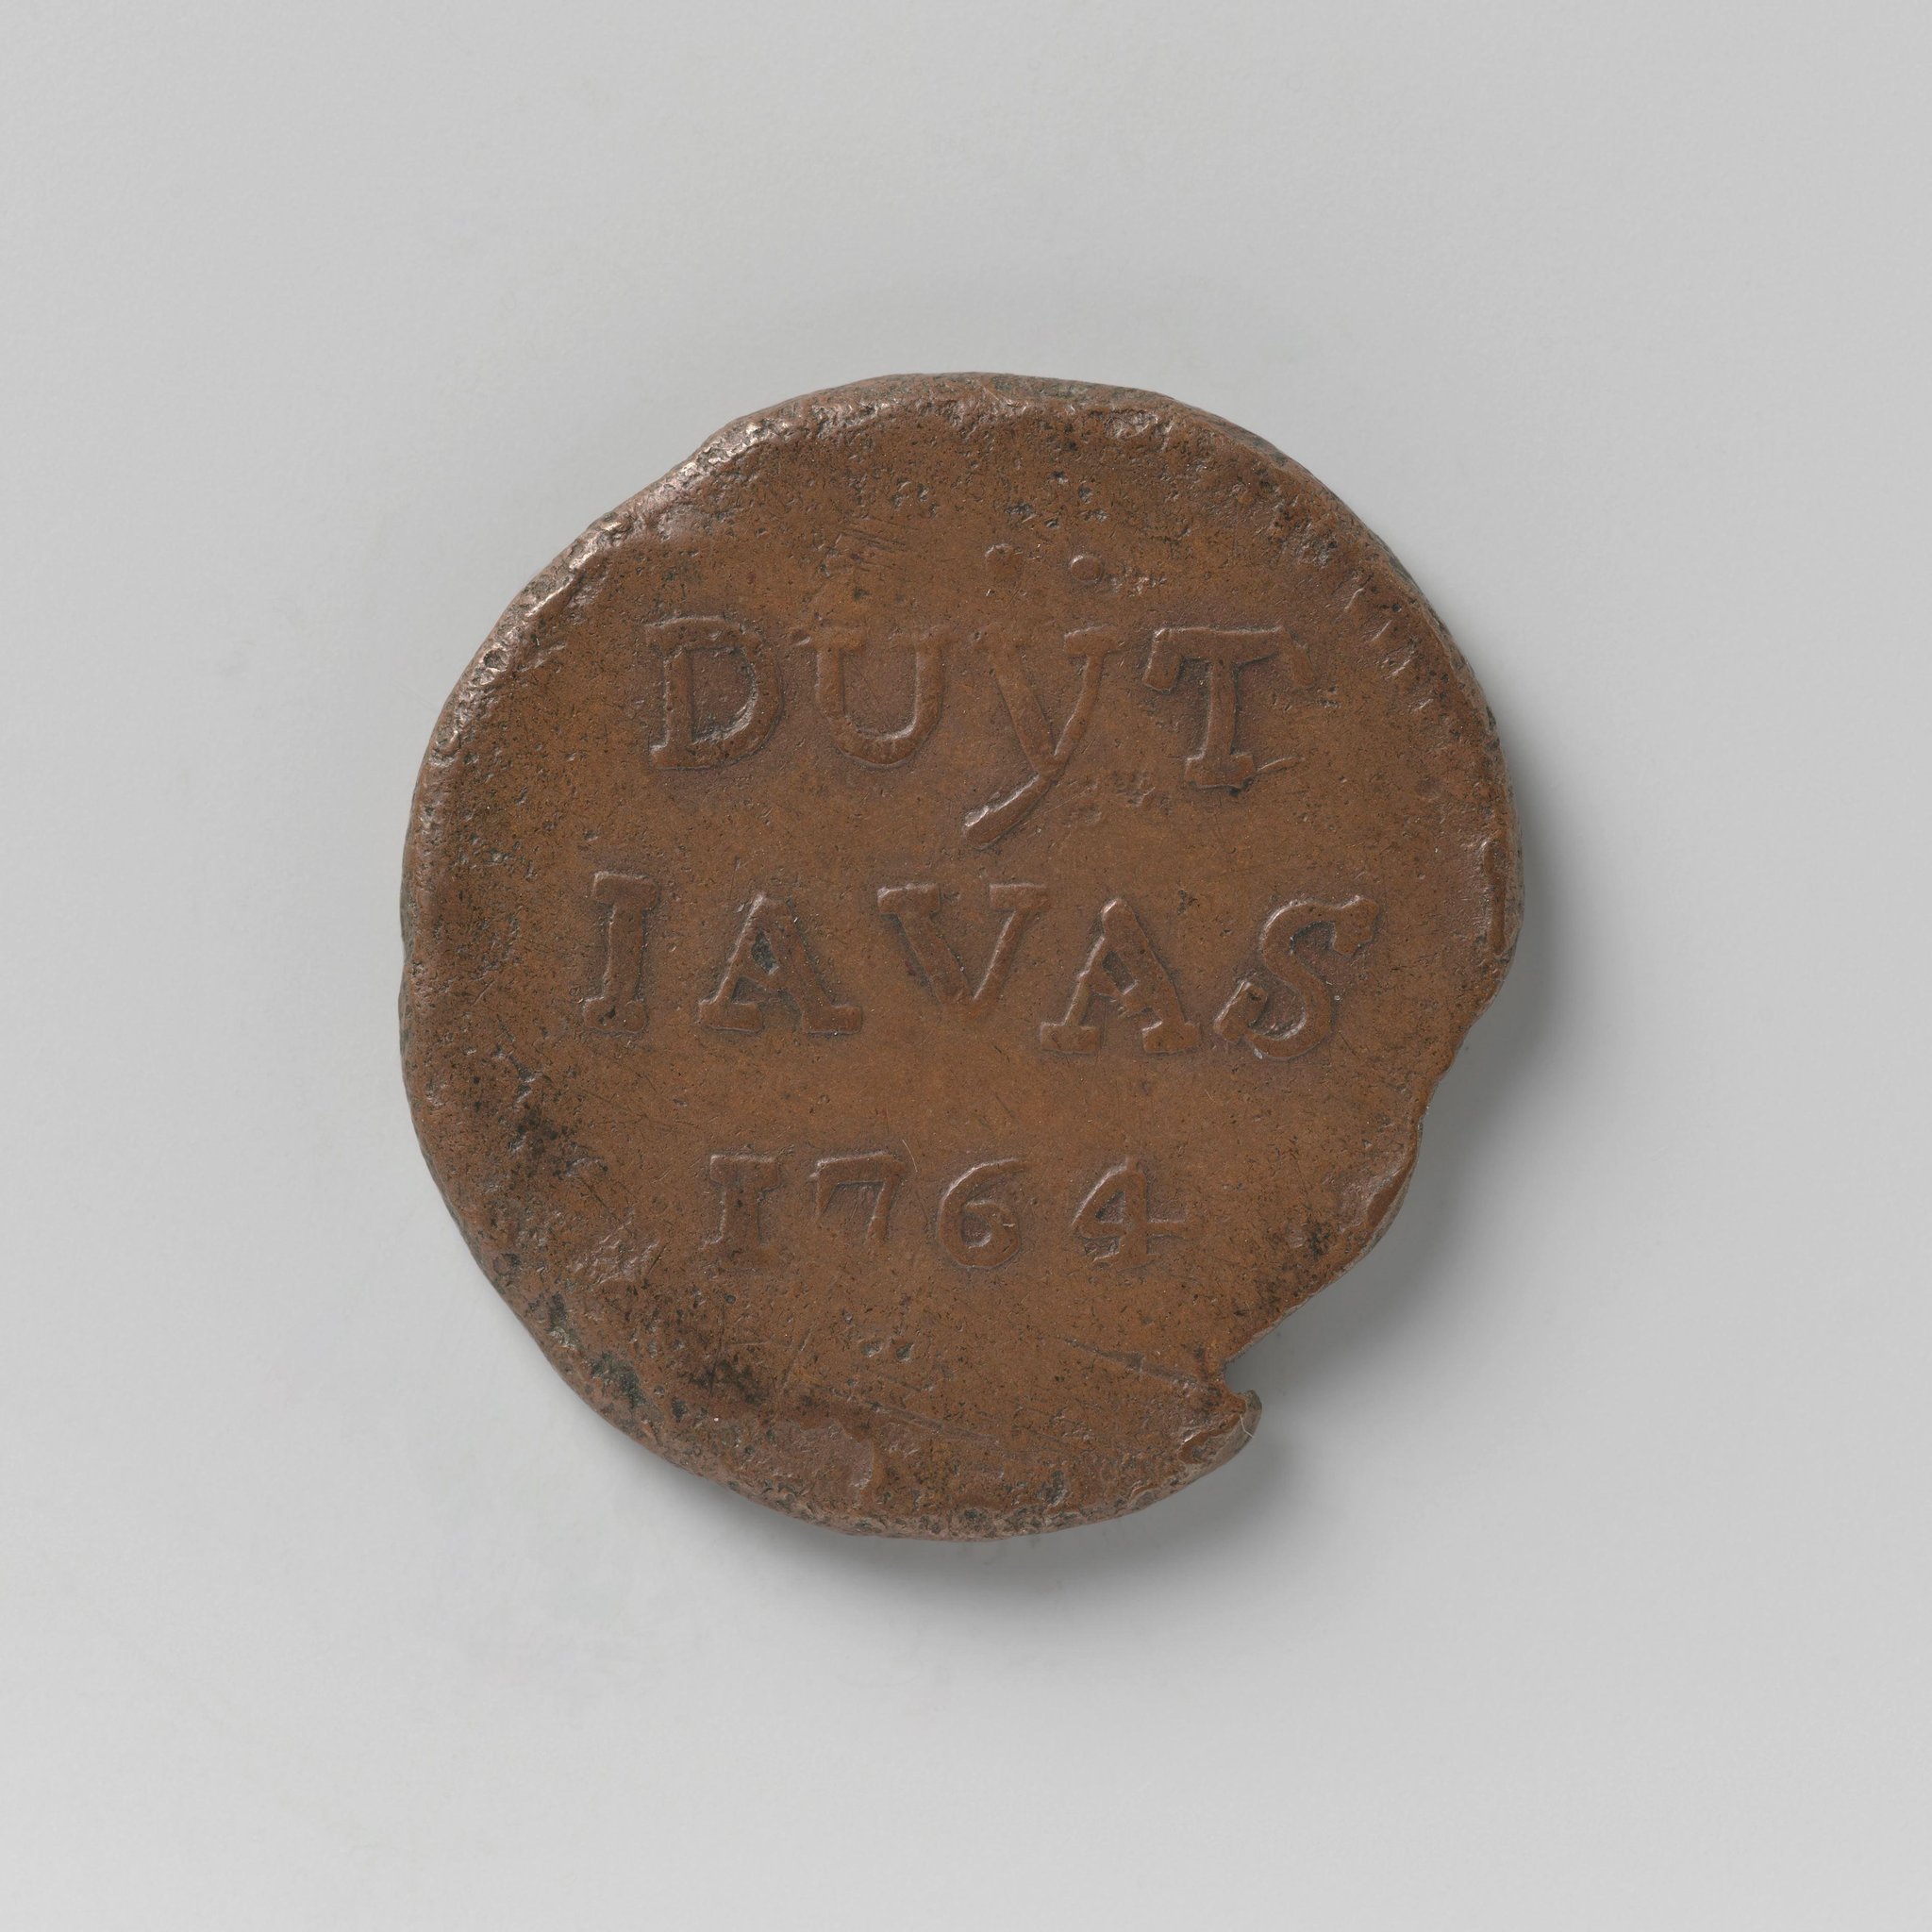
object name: coin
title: Duit van de VOC uit Java, 1764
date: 1764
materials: copper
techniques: striking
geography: batavia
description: Koperen munt. Voorzijde: tweeregelig opschrift in Latijnse letters. Daaronder jaartal in aangepaste Arabische cijfers. Keerzijde: Eensluidend tweeregelig opschrift in Arabische letters. Daaronder jaartal in oorspronkelijke Arabische cijfers. Gladde rand.